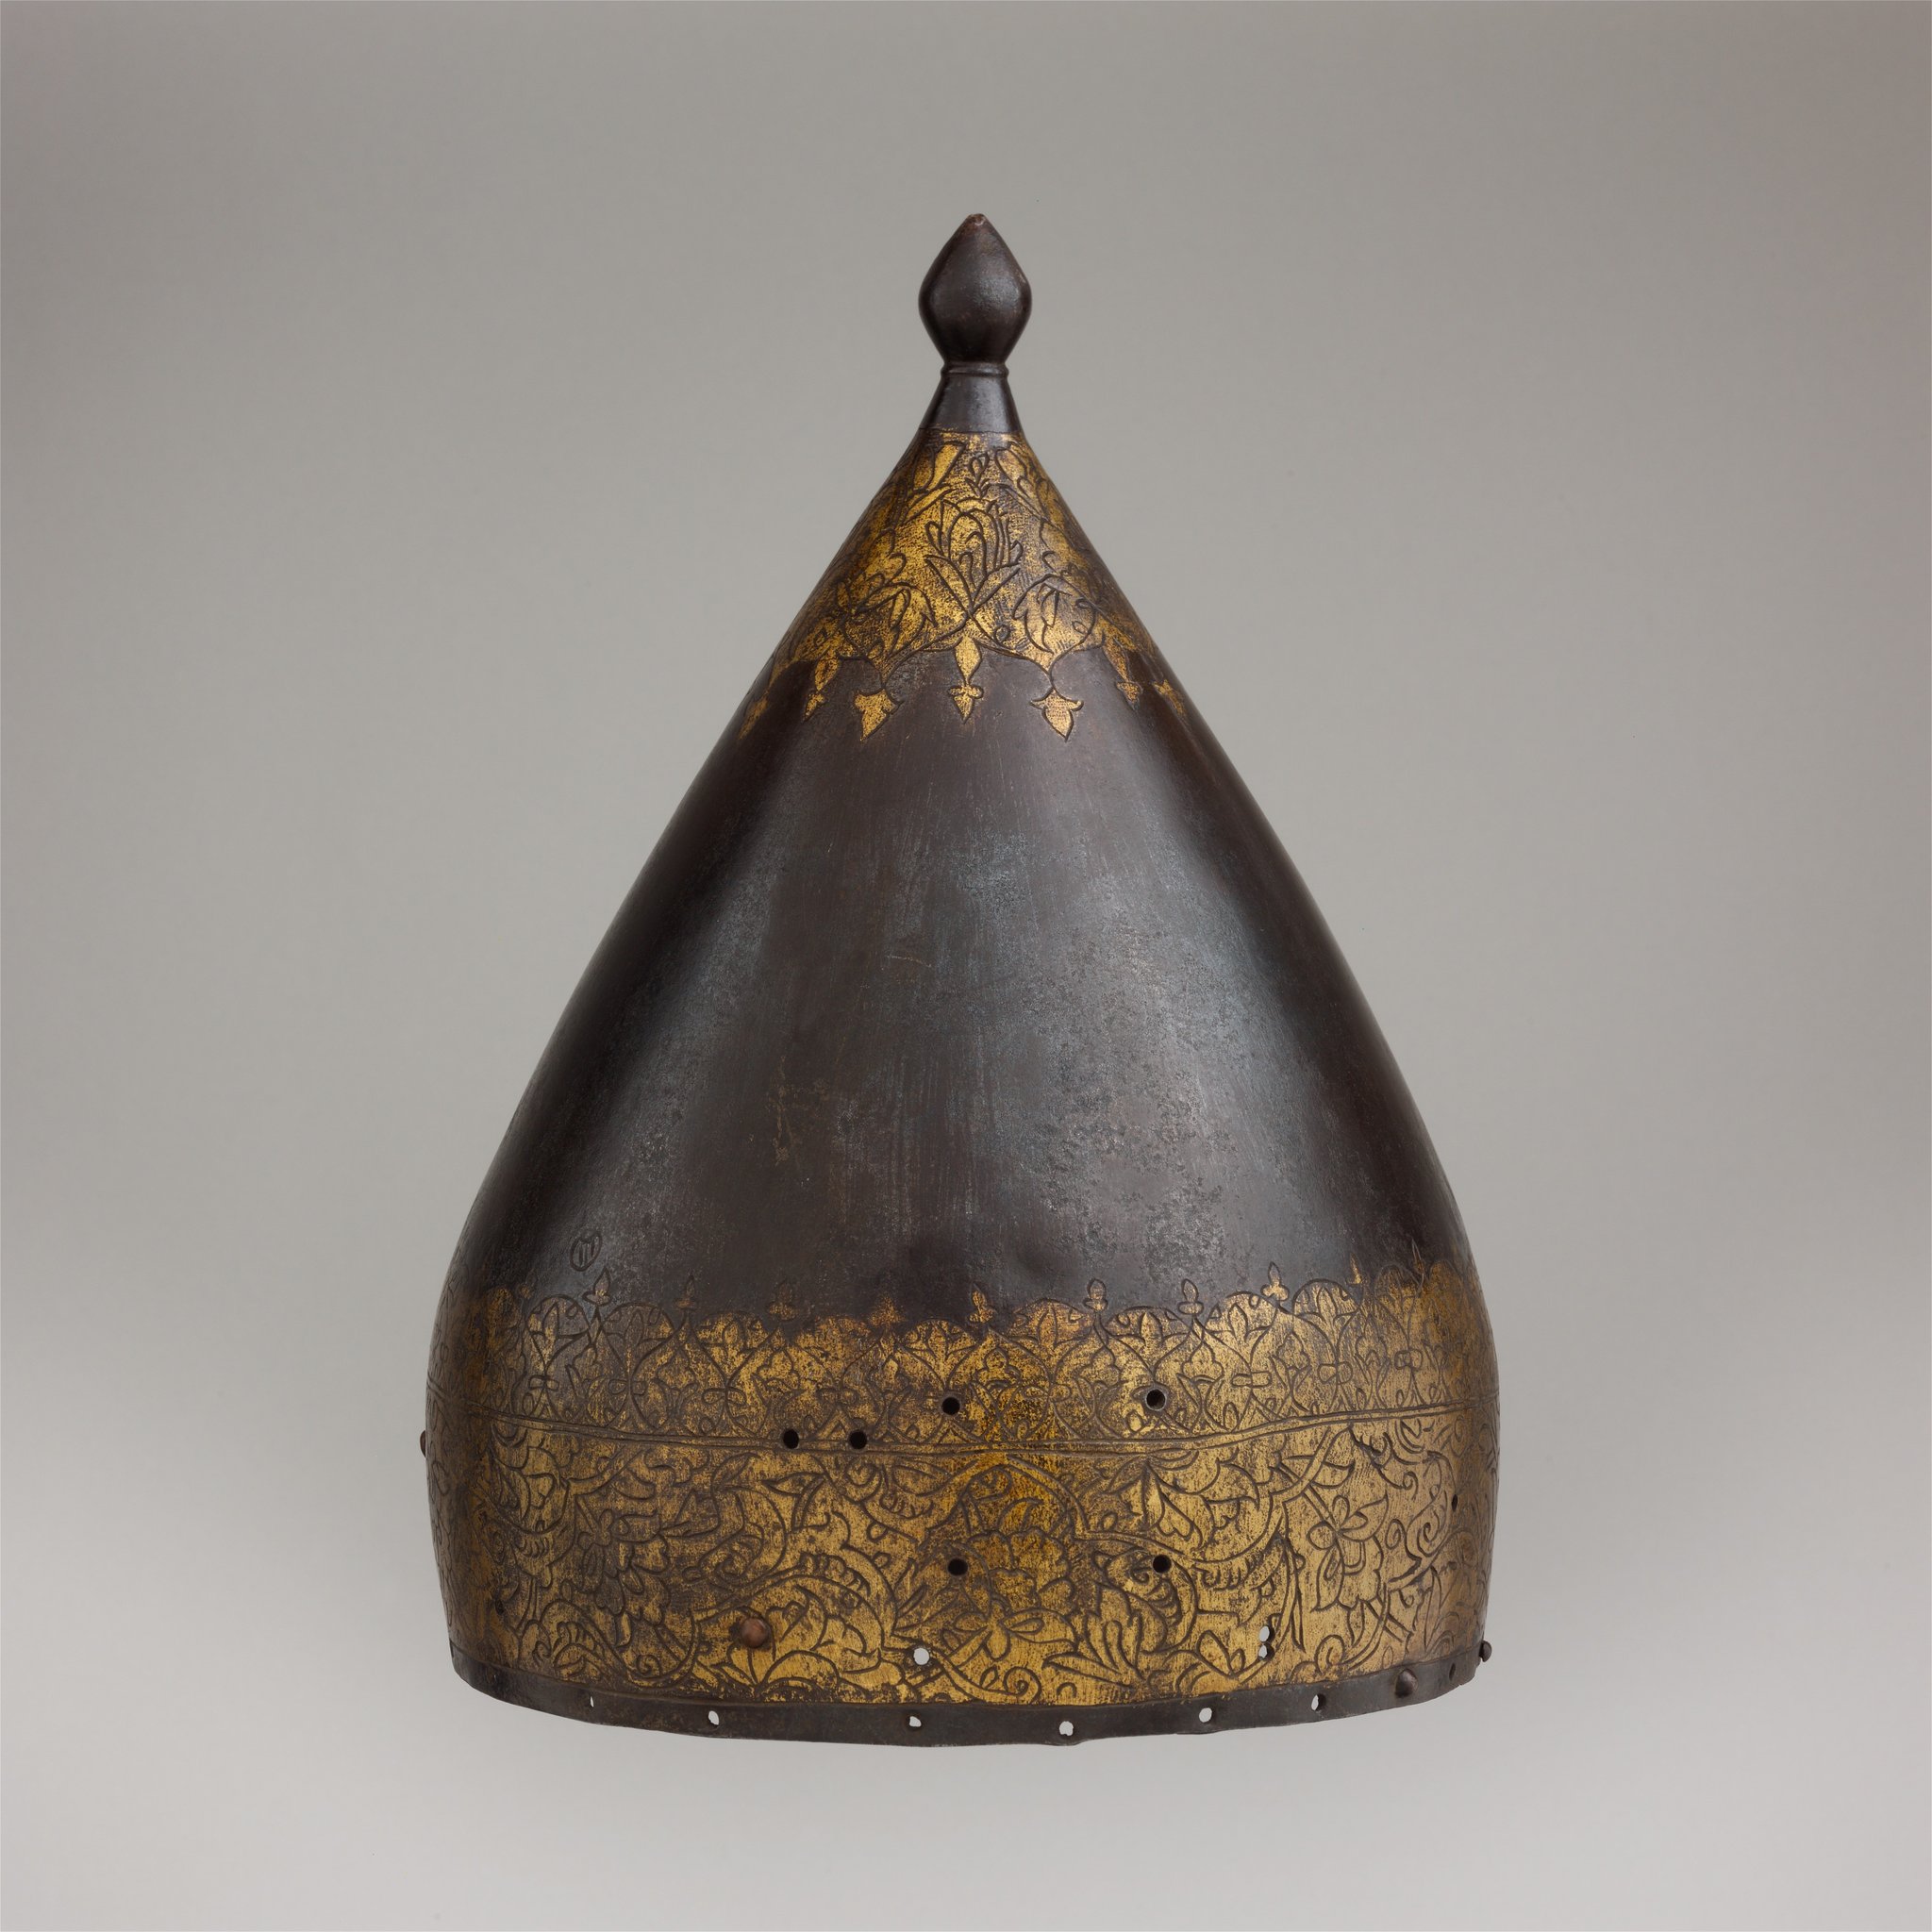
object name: helmet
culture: turkish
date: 1551-1600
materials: copper alloy, gold, steel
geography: ottoman empire